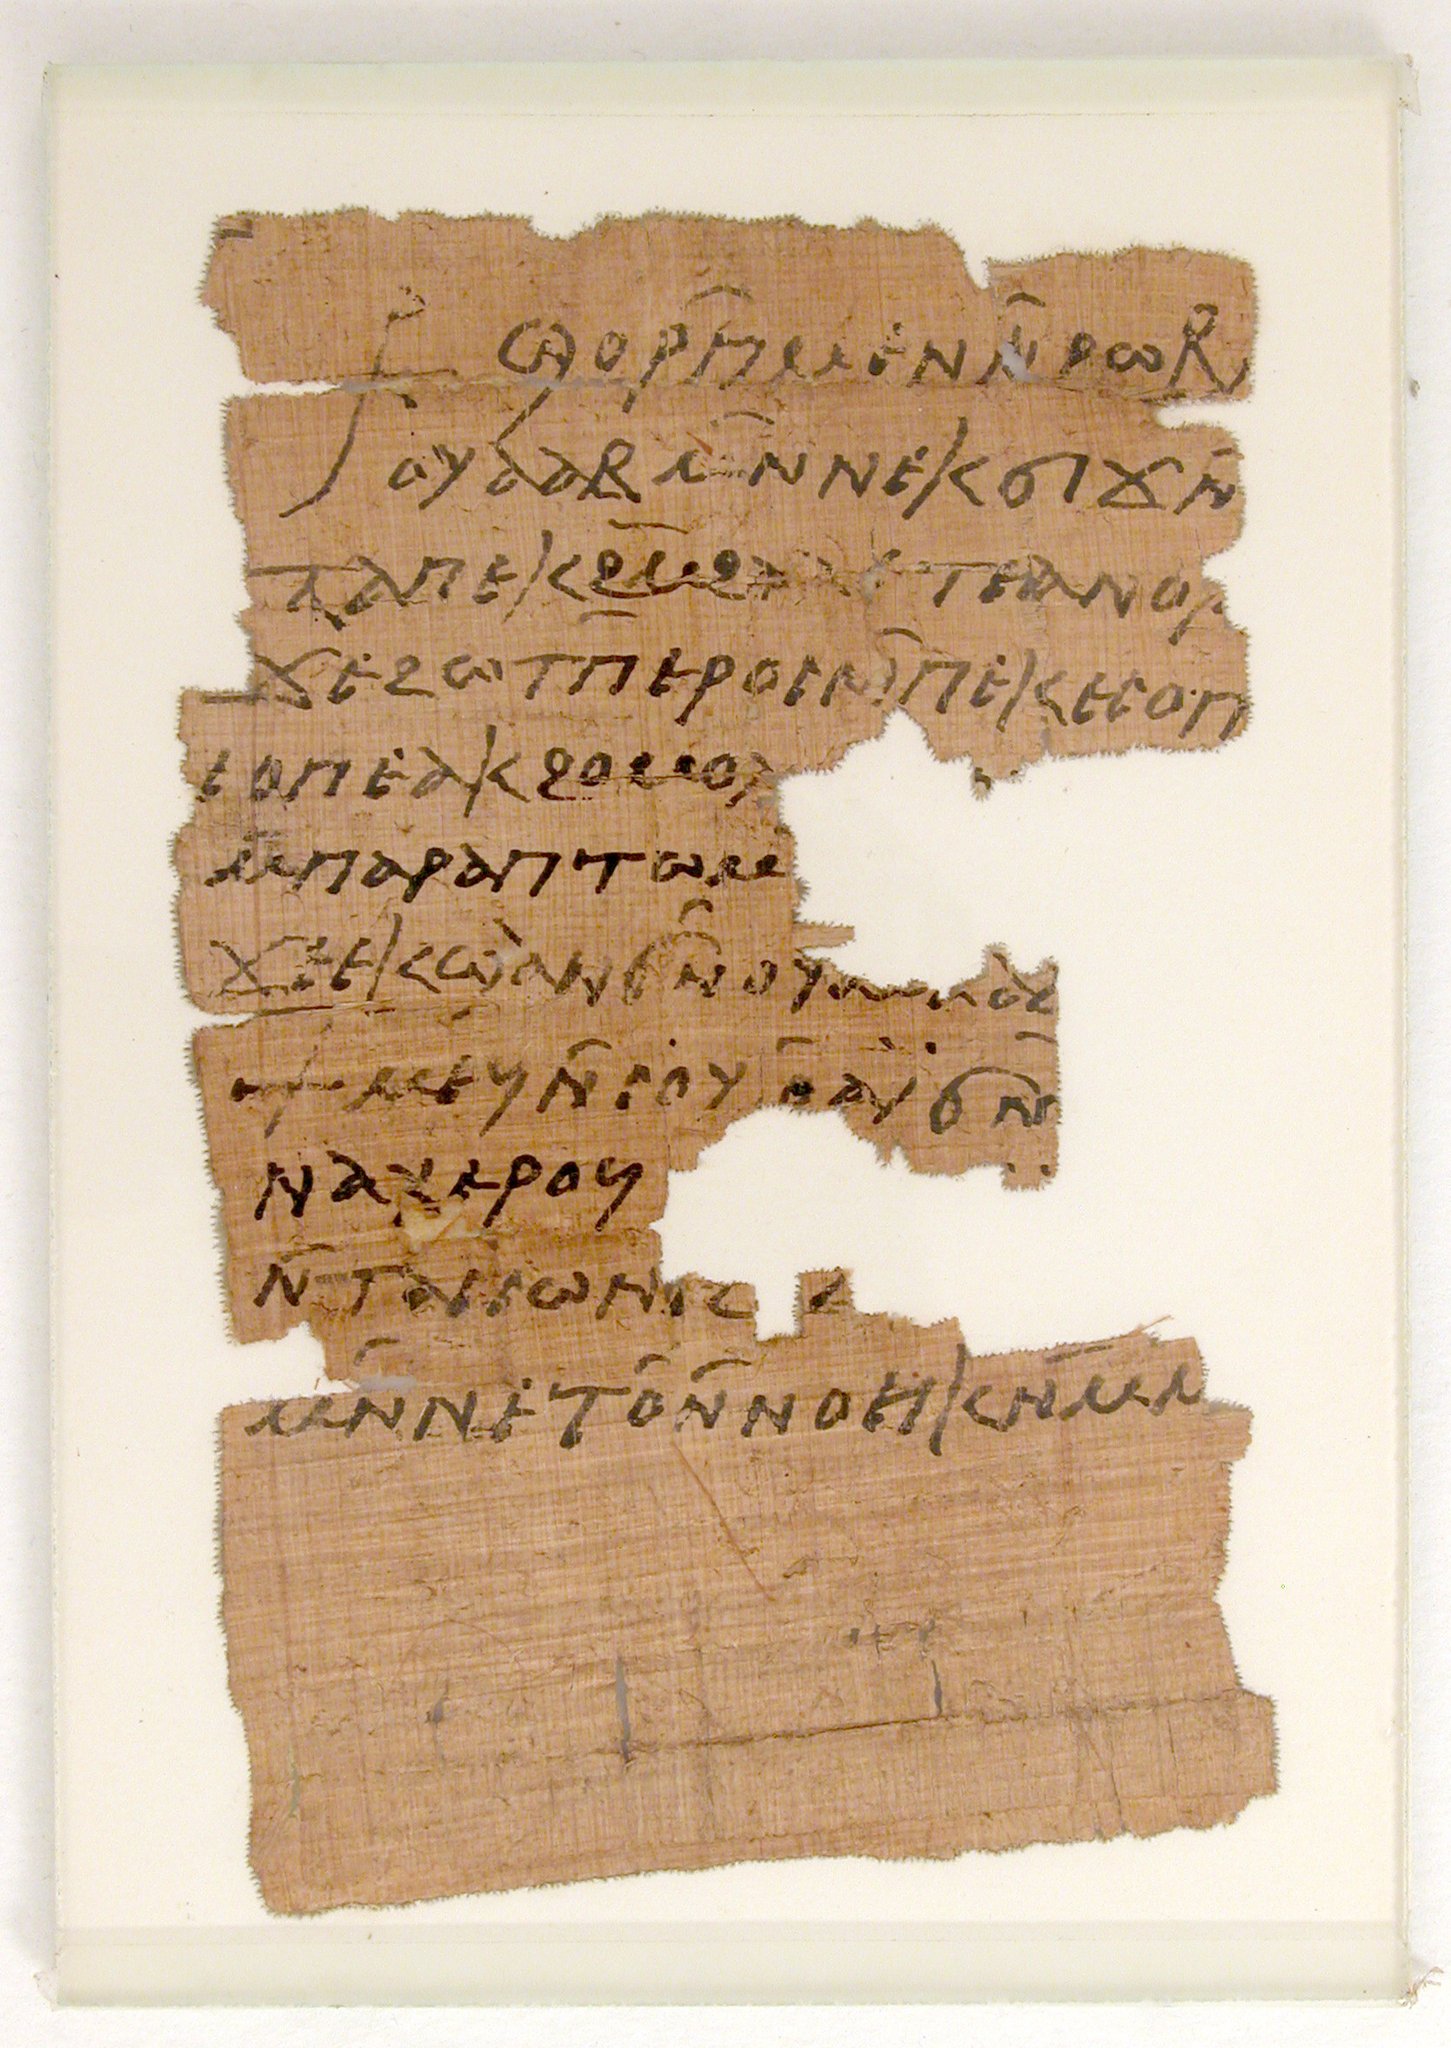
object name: fragment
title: Papyrus Fragment of a Letter from David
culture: coptic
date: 601-700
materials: ink, papyrus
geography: egypt